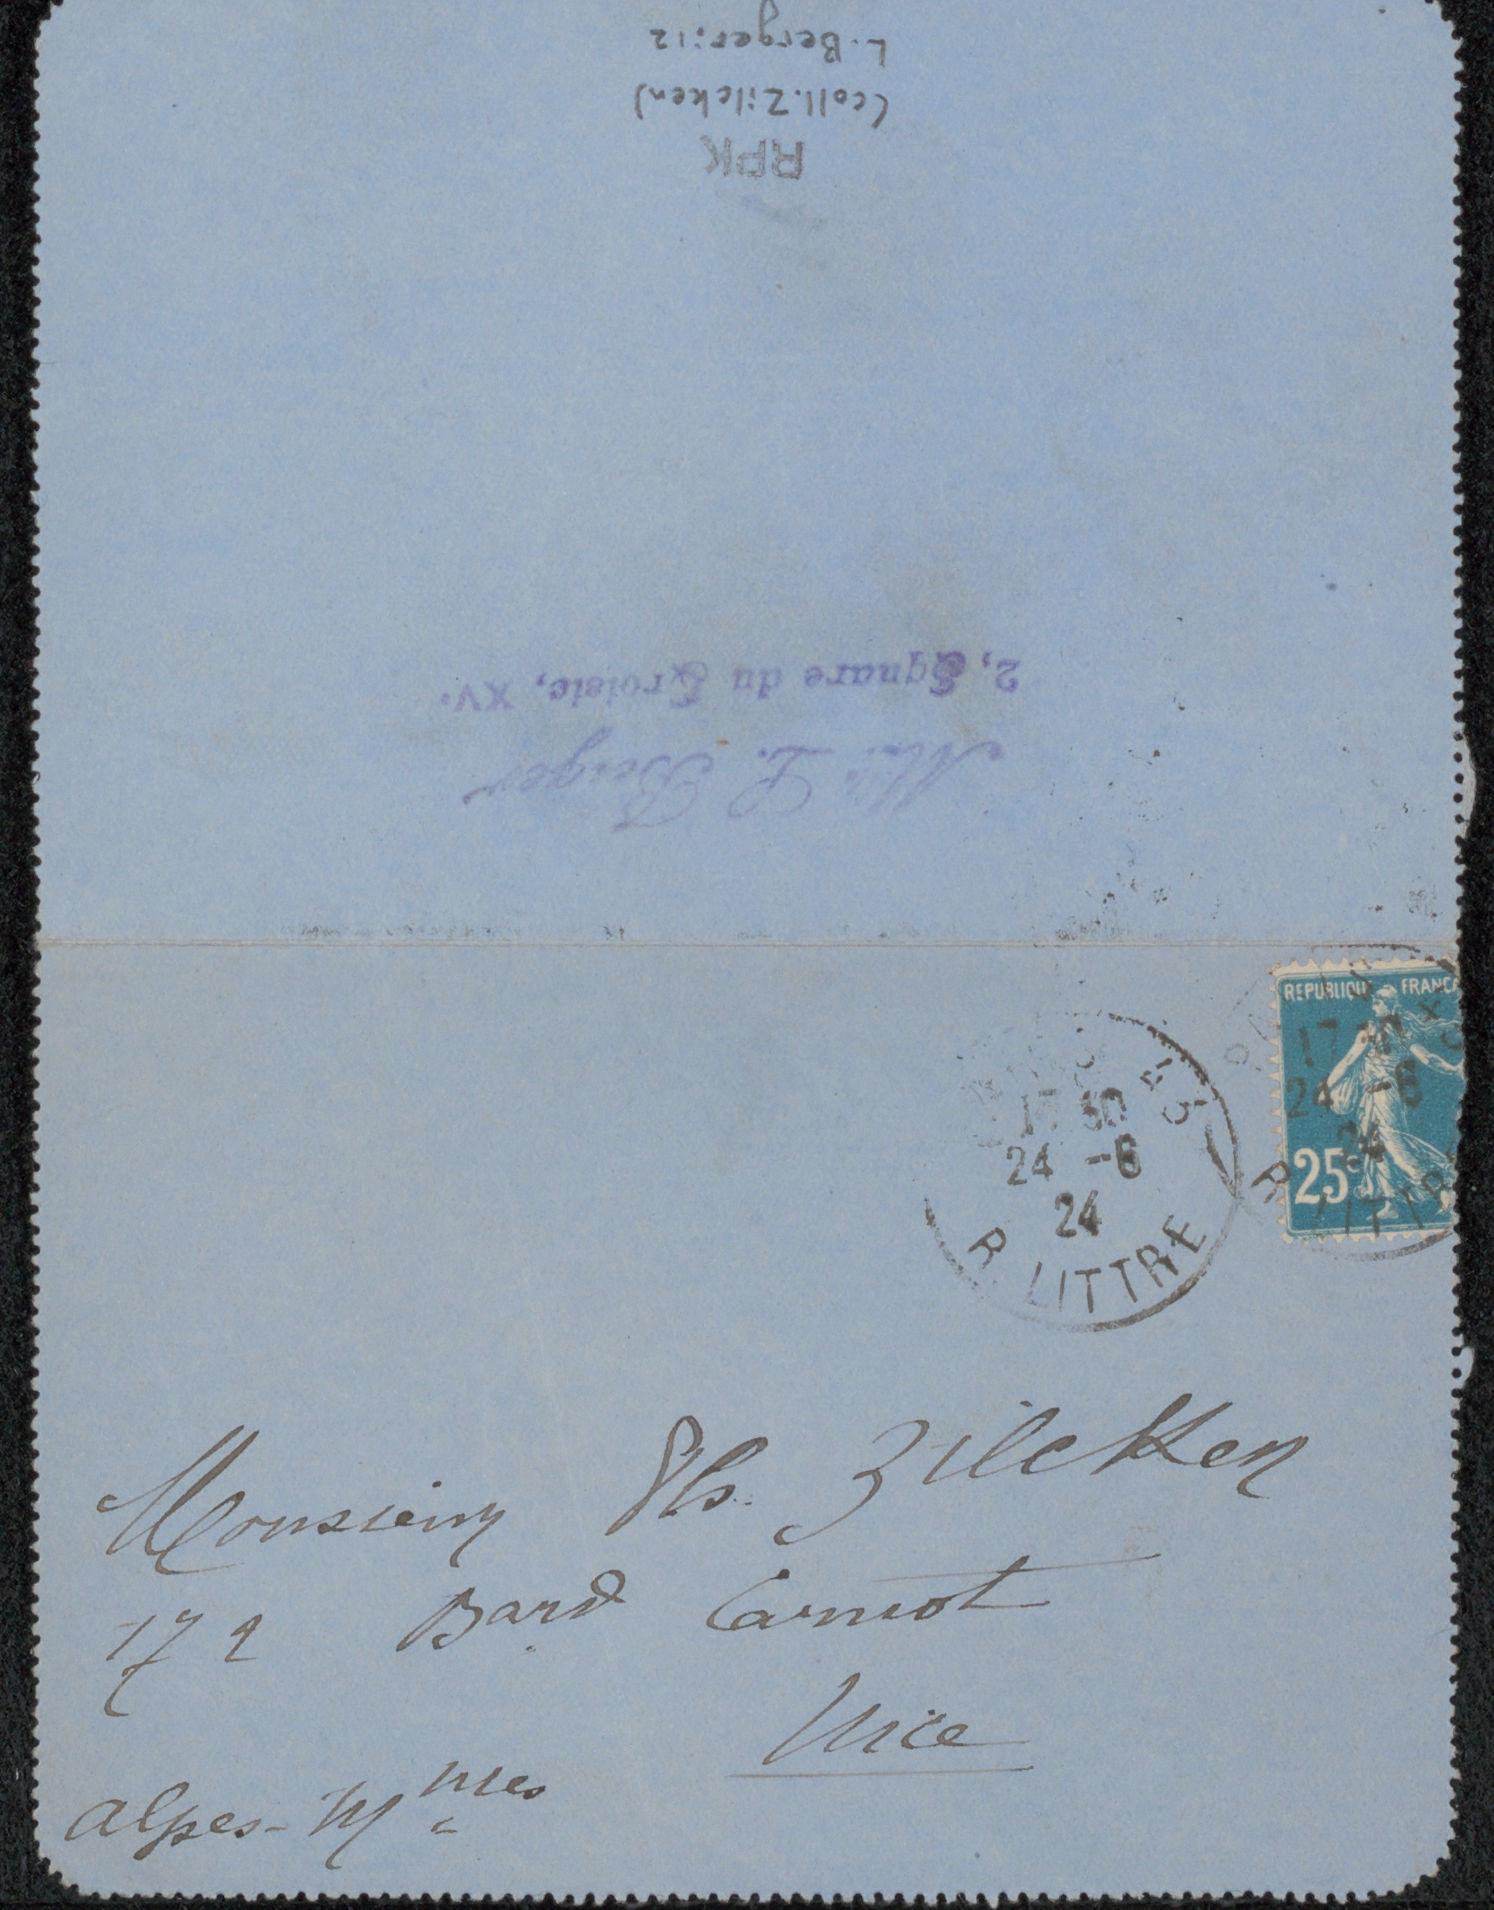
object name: letter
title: Brief aan Philip Zilcken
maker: lya berger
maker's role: schrijver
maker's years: 1877-1941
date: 1924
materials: ink, paper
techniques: pen, writing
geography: paris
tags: nijmegen, adriaan pit, maria biermé, painter, draughtsman, philip zilcken, paris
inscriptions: collector's mark: ‘RPK’, address: ‘Mlle. L. Berger/ 2, Square du Croisic, XVe’